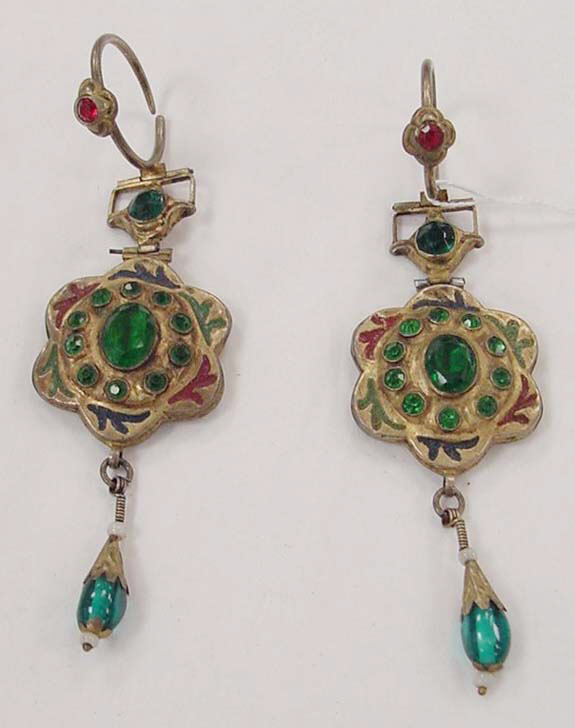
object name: earring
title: Earrings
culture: indian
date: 1801-1900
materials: metal, stone